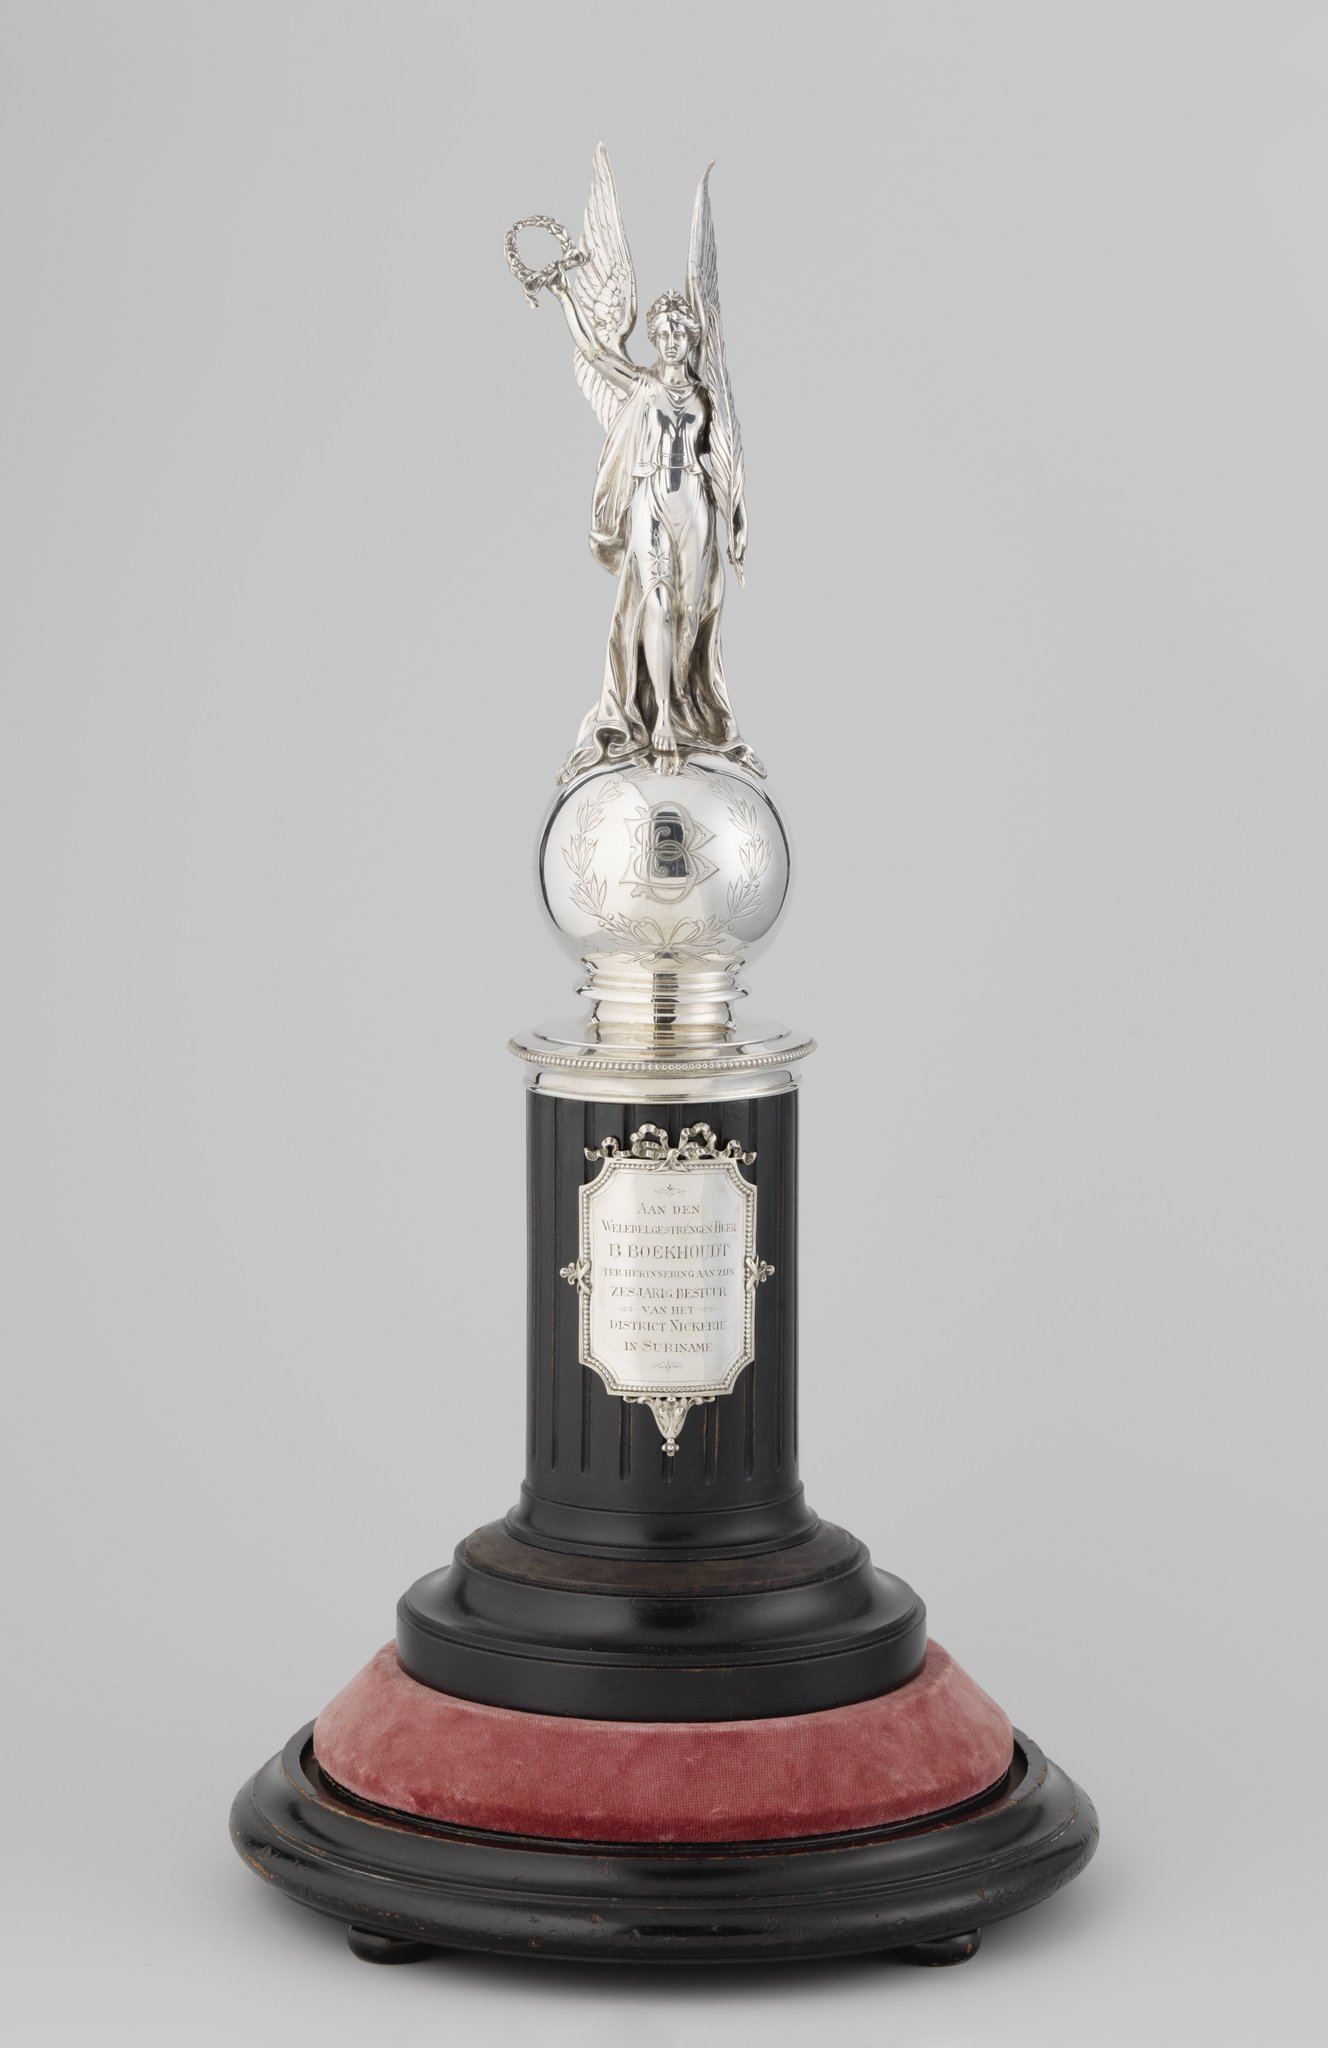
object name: gedenkstuk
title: Gedenkstuk voor B. Boekhoudt, districts-commissaris van Nickerie in Suriname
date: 1909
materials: silver, velvet, wood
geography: the hague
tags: bernardus boekhoudt, nickerie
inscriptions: inscription: ‘Aan den weleldelgestrengen heer B. Boekhoudt ter herinnering aan zijn zesjarig bestuur van het district Nickerie in Suriname’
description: Gedenkstuk, voorstellende een gevleugelde vrouw met in haar rechterhand een lauwerkrans en in haar linkerhand een palmtak uitgevoerd in zilver, staande op een zilveren bol waarop de initialen BB zijn gegraveerd. Dit beeld staat op een ronde houten sokkel waarop een zilveren plaatje is gemonteerd met de tekst: Aan den weleldelgestrengen heer B. Boekhoudt ter herinnering aan zijn zesjarig bestuur van het district Nickerie in Suriname.